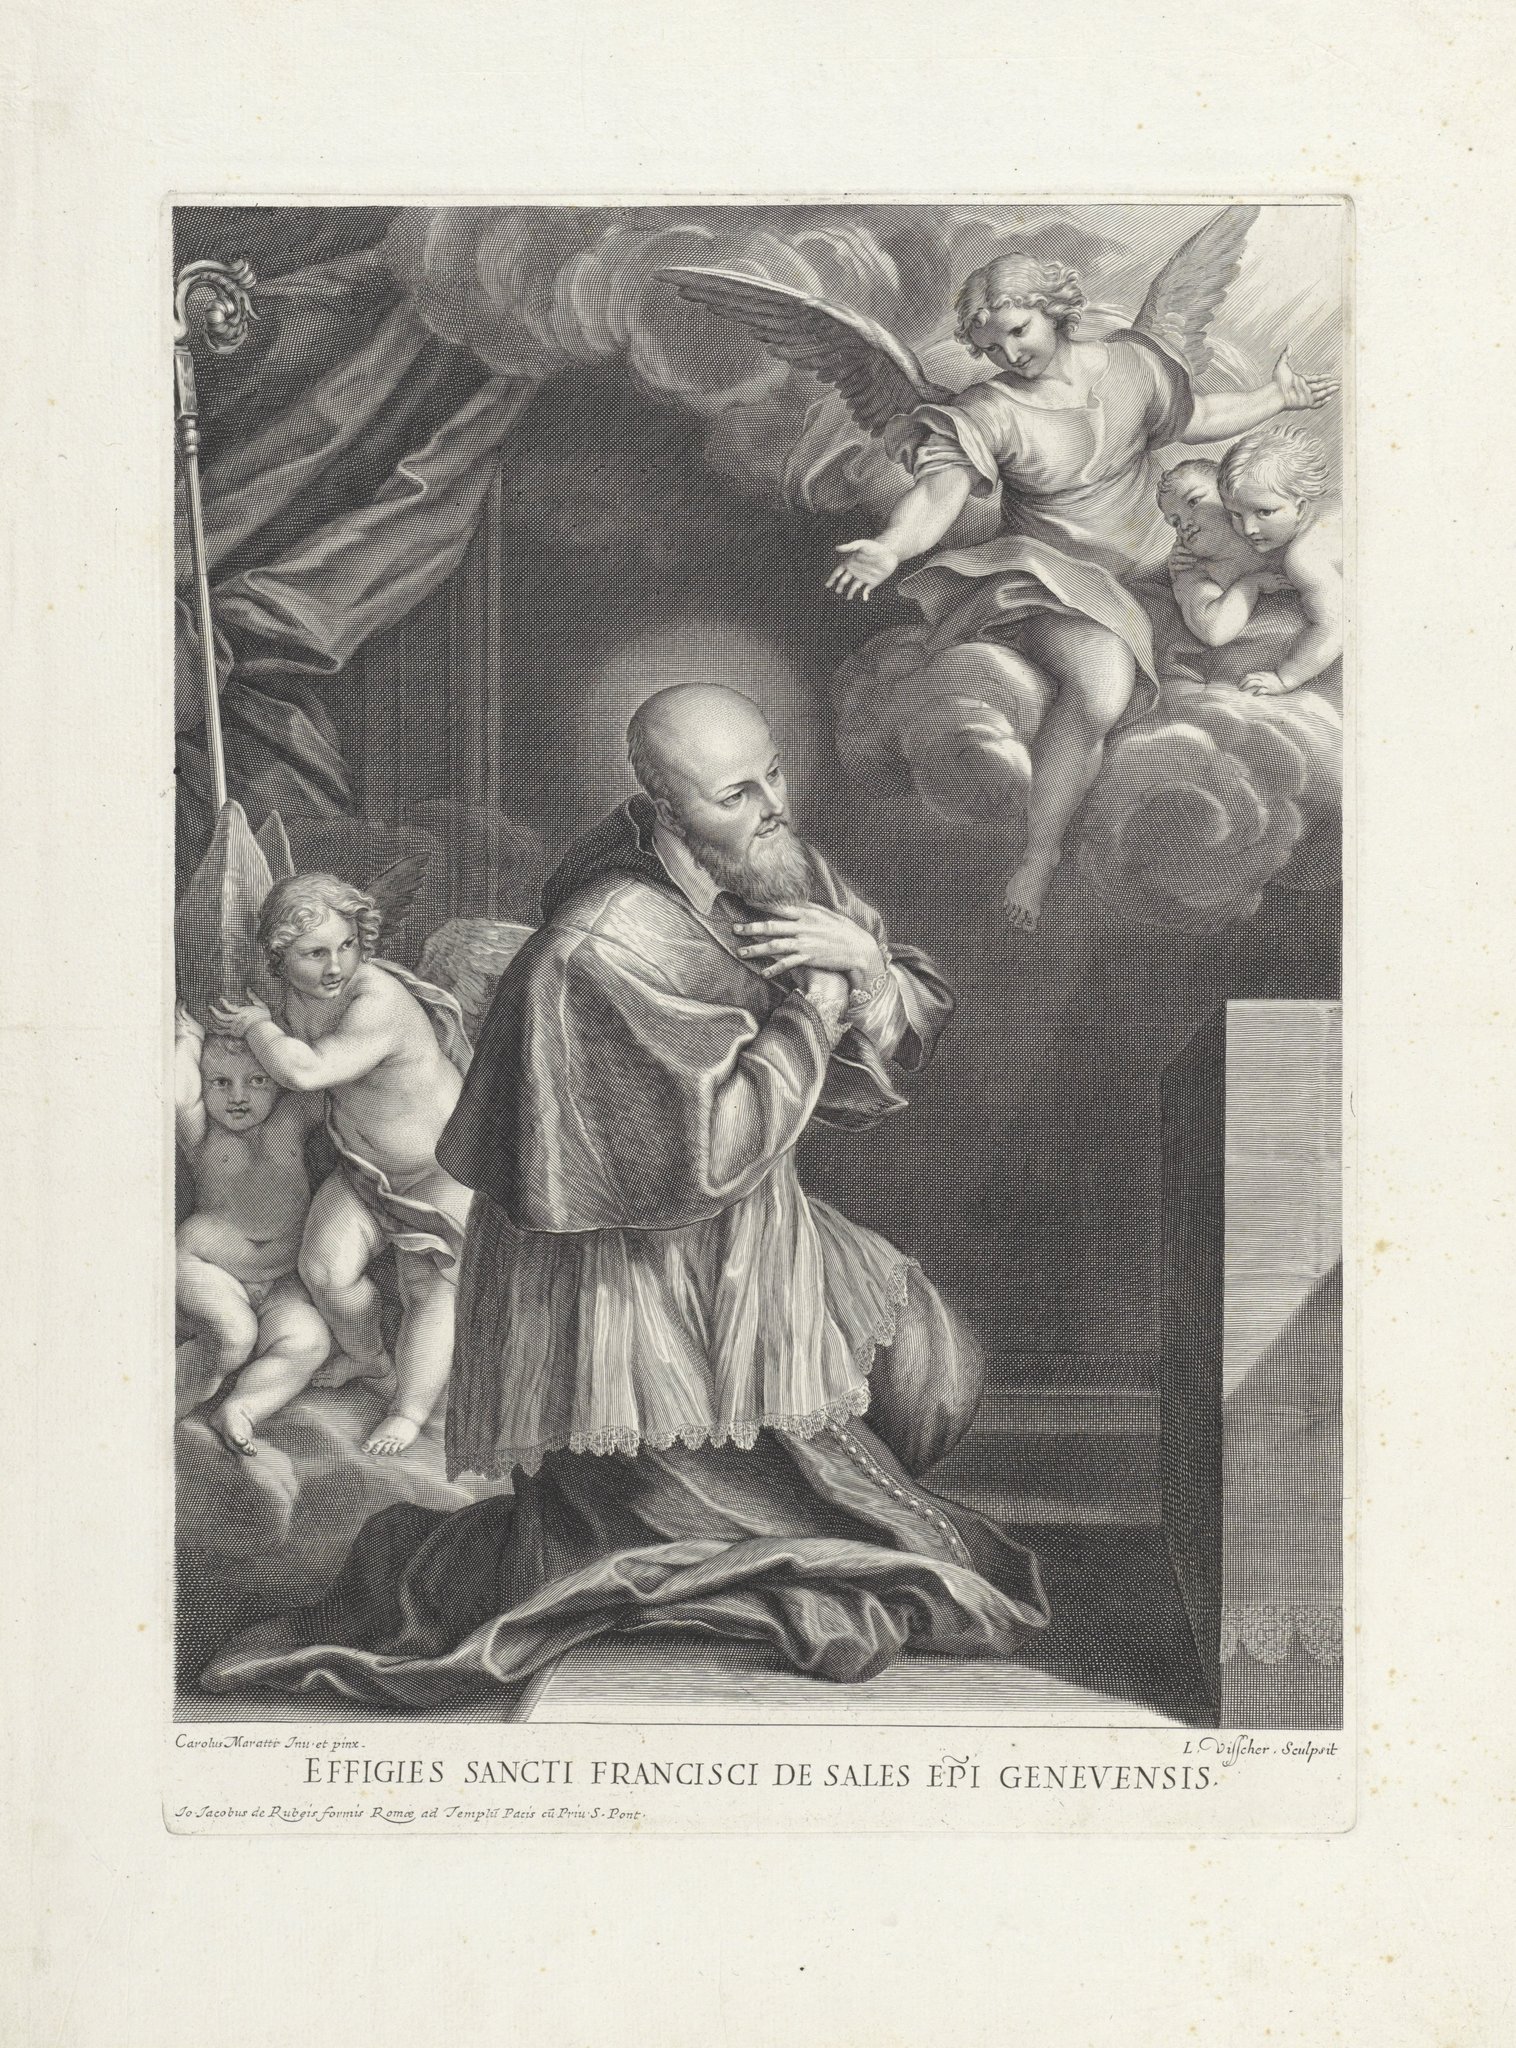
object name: print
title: H. Franciscus van Sales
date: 1643-1691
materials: paper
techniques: engraving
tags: the bishop of geneva and doctor of the church, francis of sales; possible attributes: heart entwined with thorns, archbishop, bishop, etc. (roman catholic), angels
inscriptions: collector's mark: Lugt 240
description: De H. Franciscus van Sales zit geknield op de grond, gekleed als bisschop. In de lucht engelen op een wolk. Achter hem twee engeltjes met zijn bisschopsmijter en zijn staf.